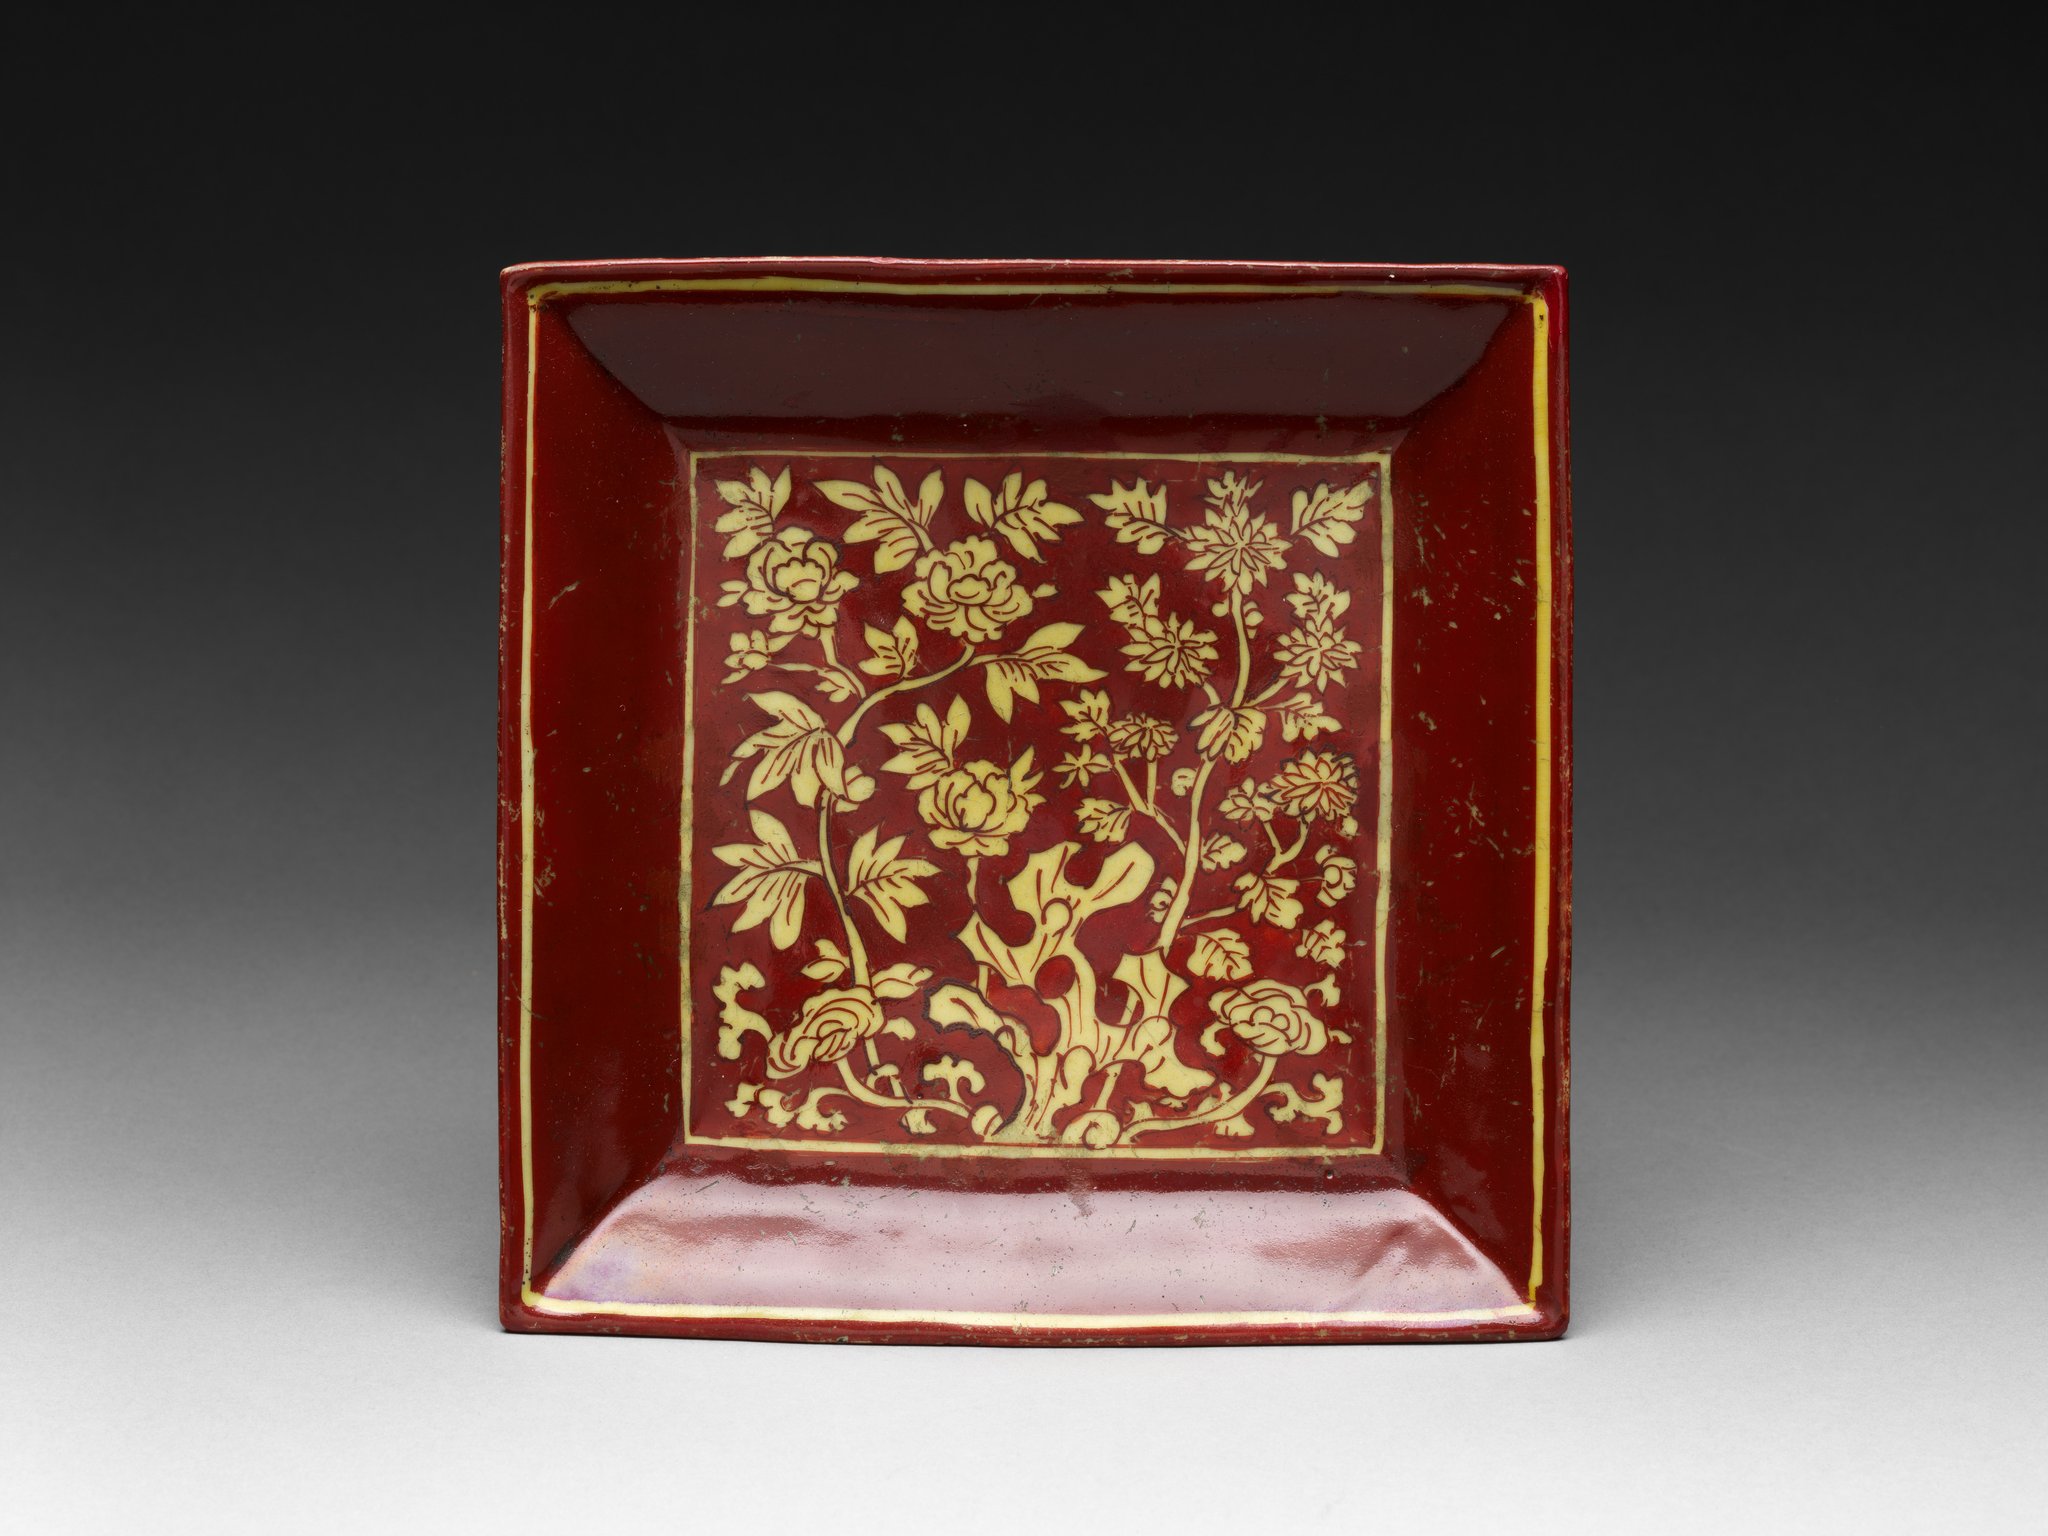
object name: dish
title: Dish with Rock, Peonies, Chrysanthemums, and Fungus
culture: chinese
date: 1534-1566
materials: enamel, glaze, porcelain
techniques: painting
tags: peonies,leaves